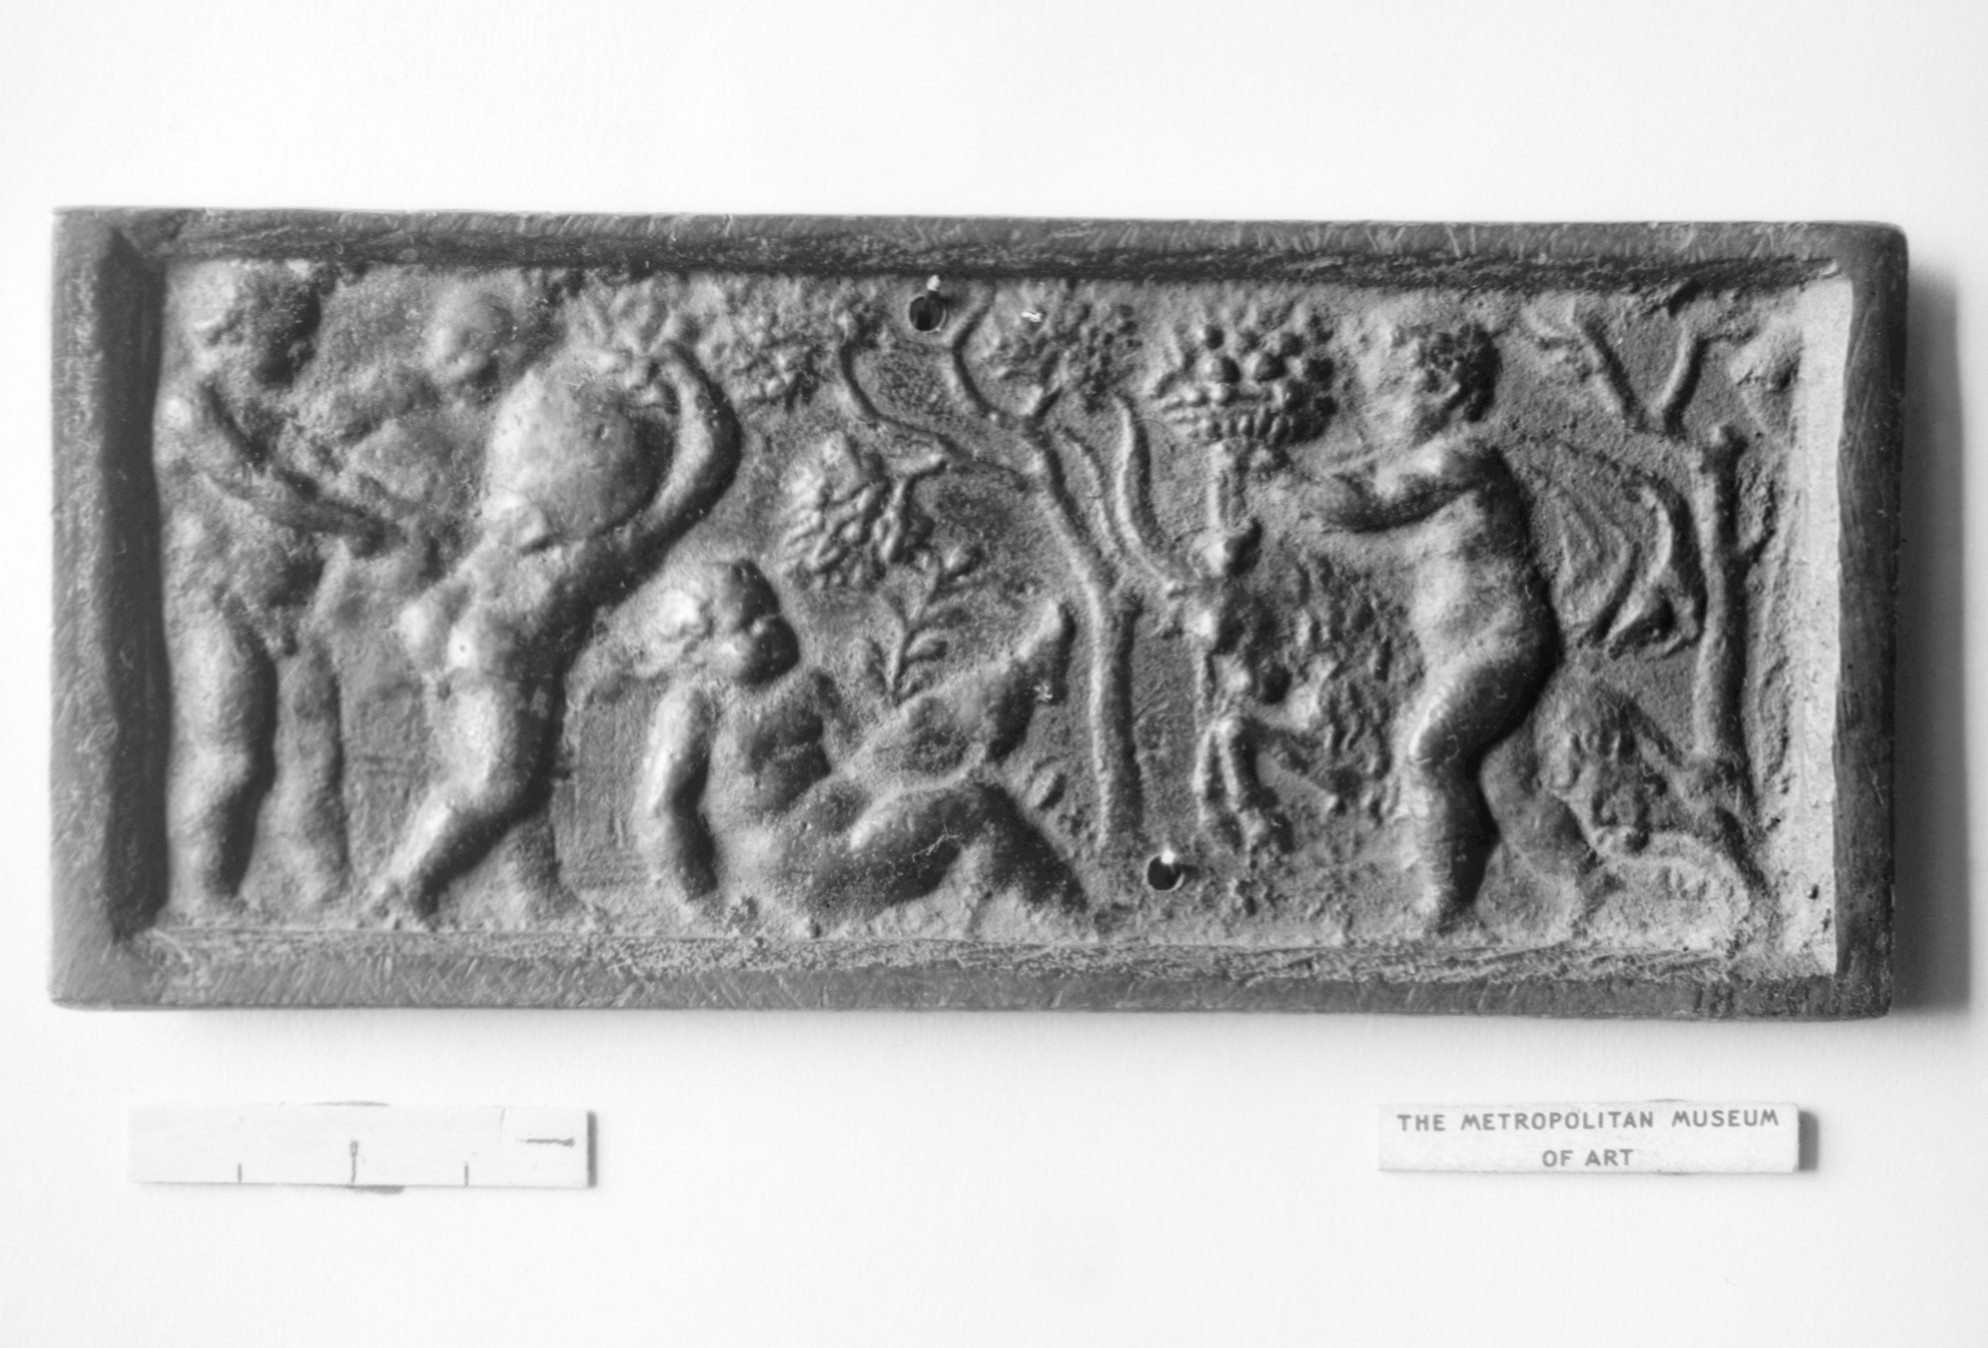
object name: plaquette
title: Bacchanal of Children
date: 1501-1533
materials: bronze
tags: children,putti,trees